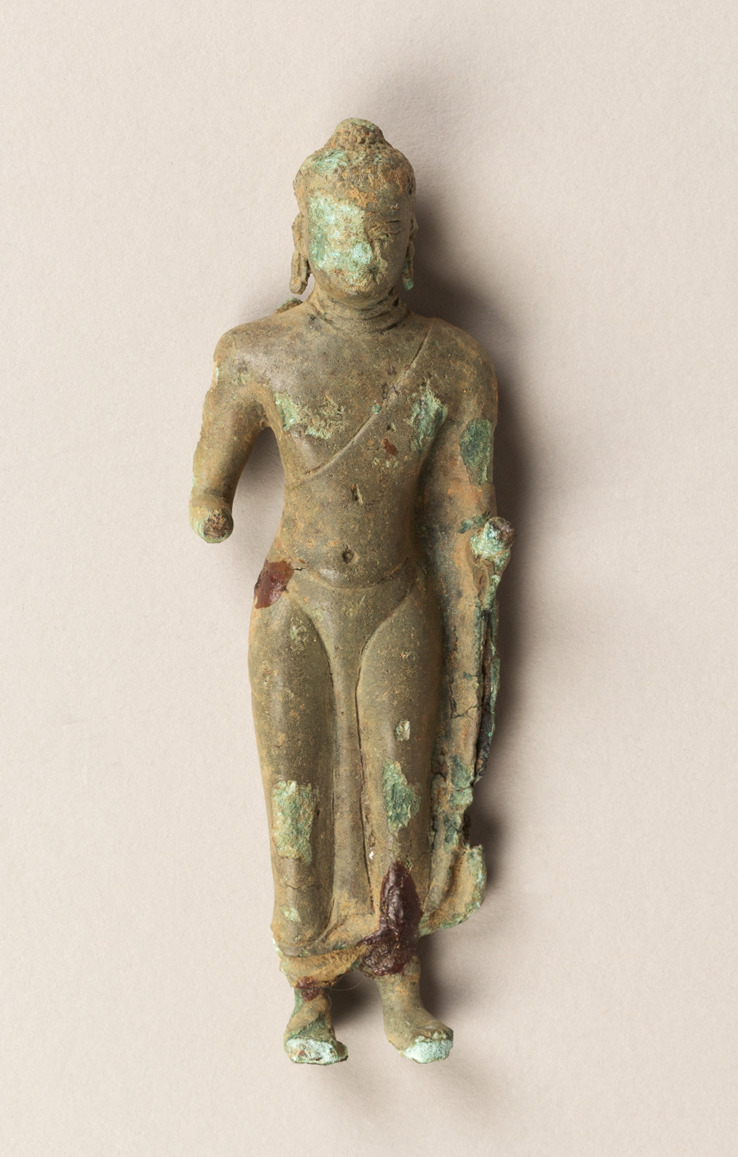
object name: fragment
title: Fragment of a Standing Buddha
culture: indonesian, kalimantan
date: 701-800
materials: bronze